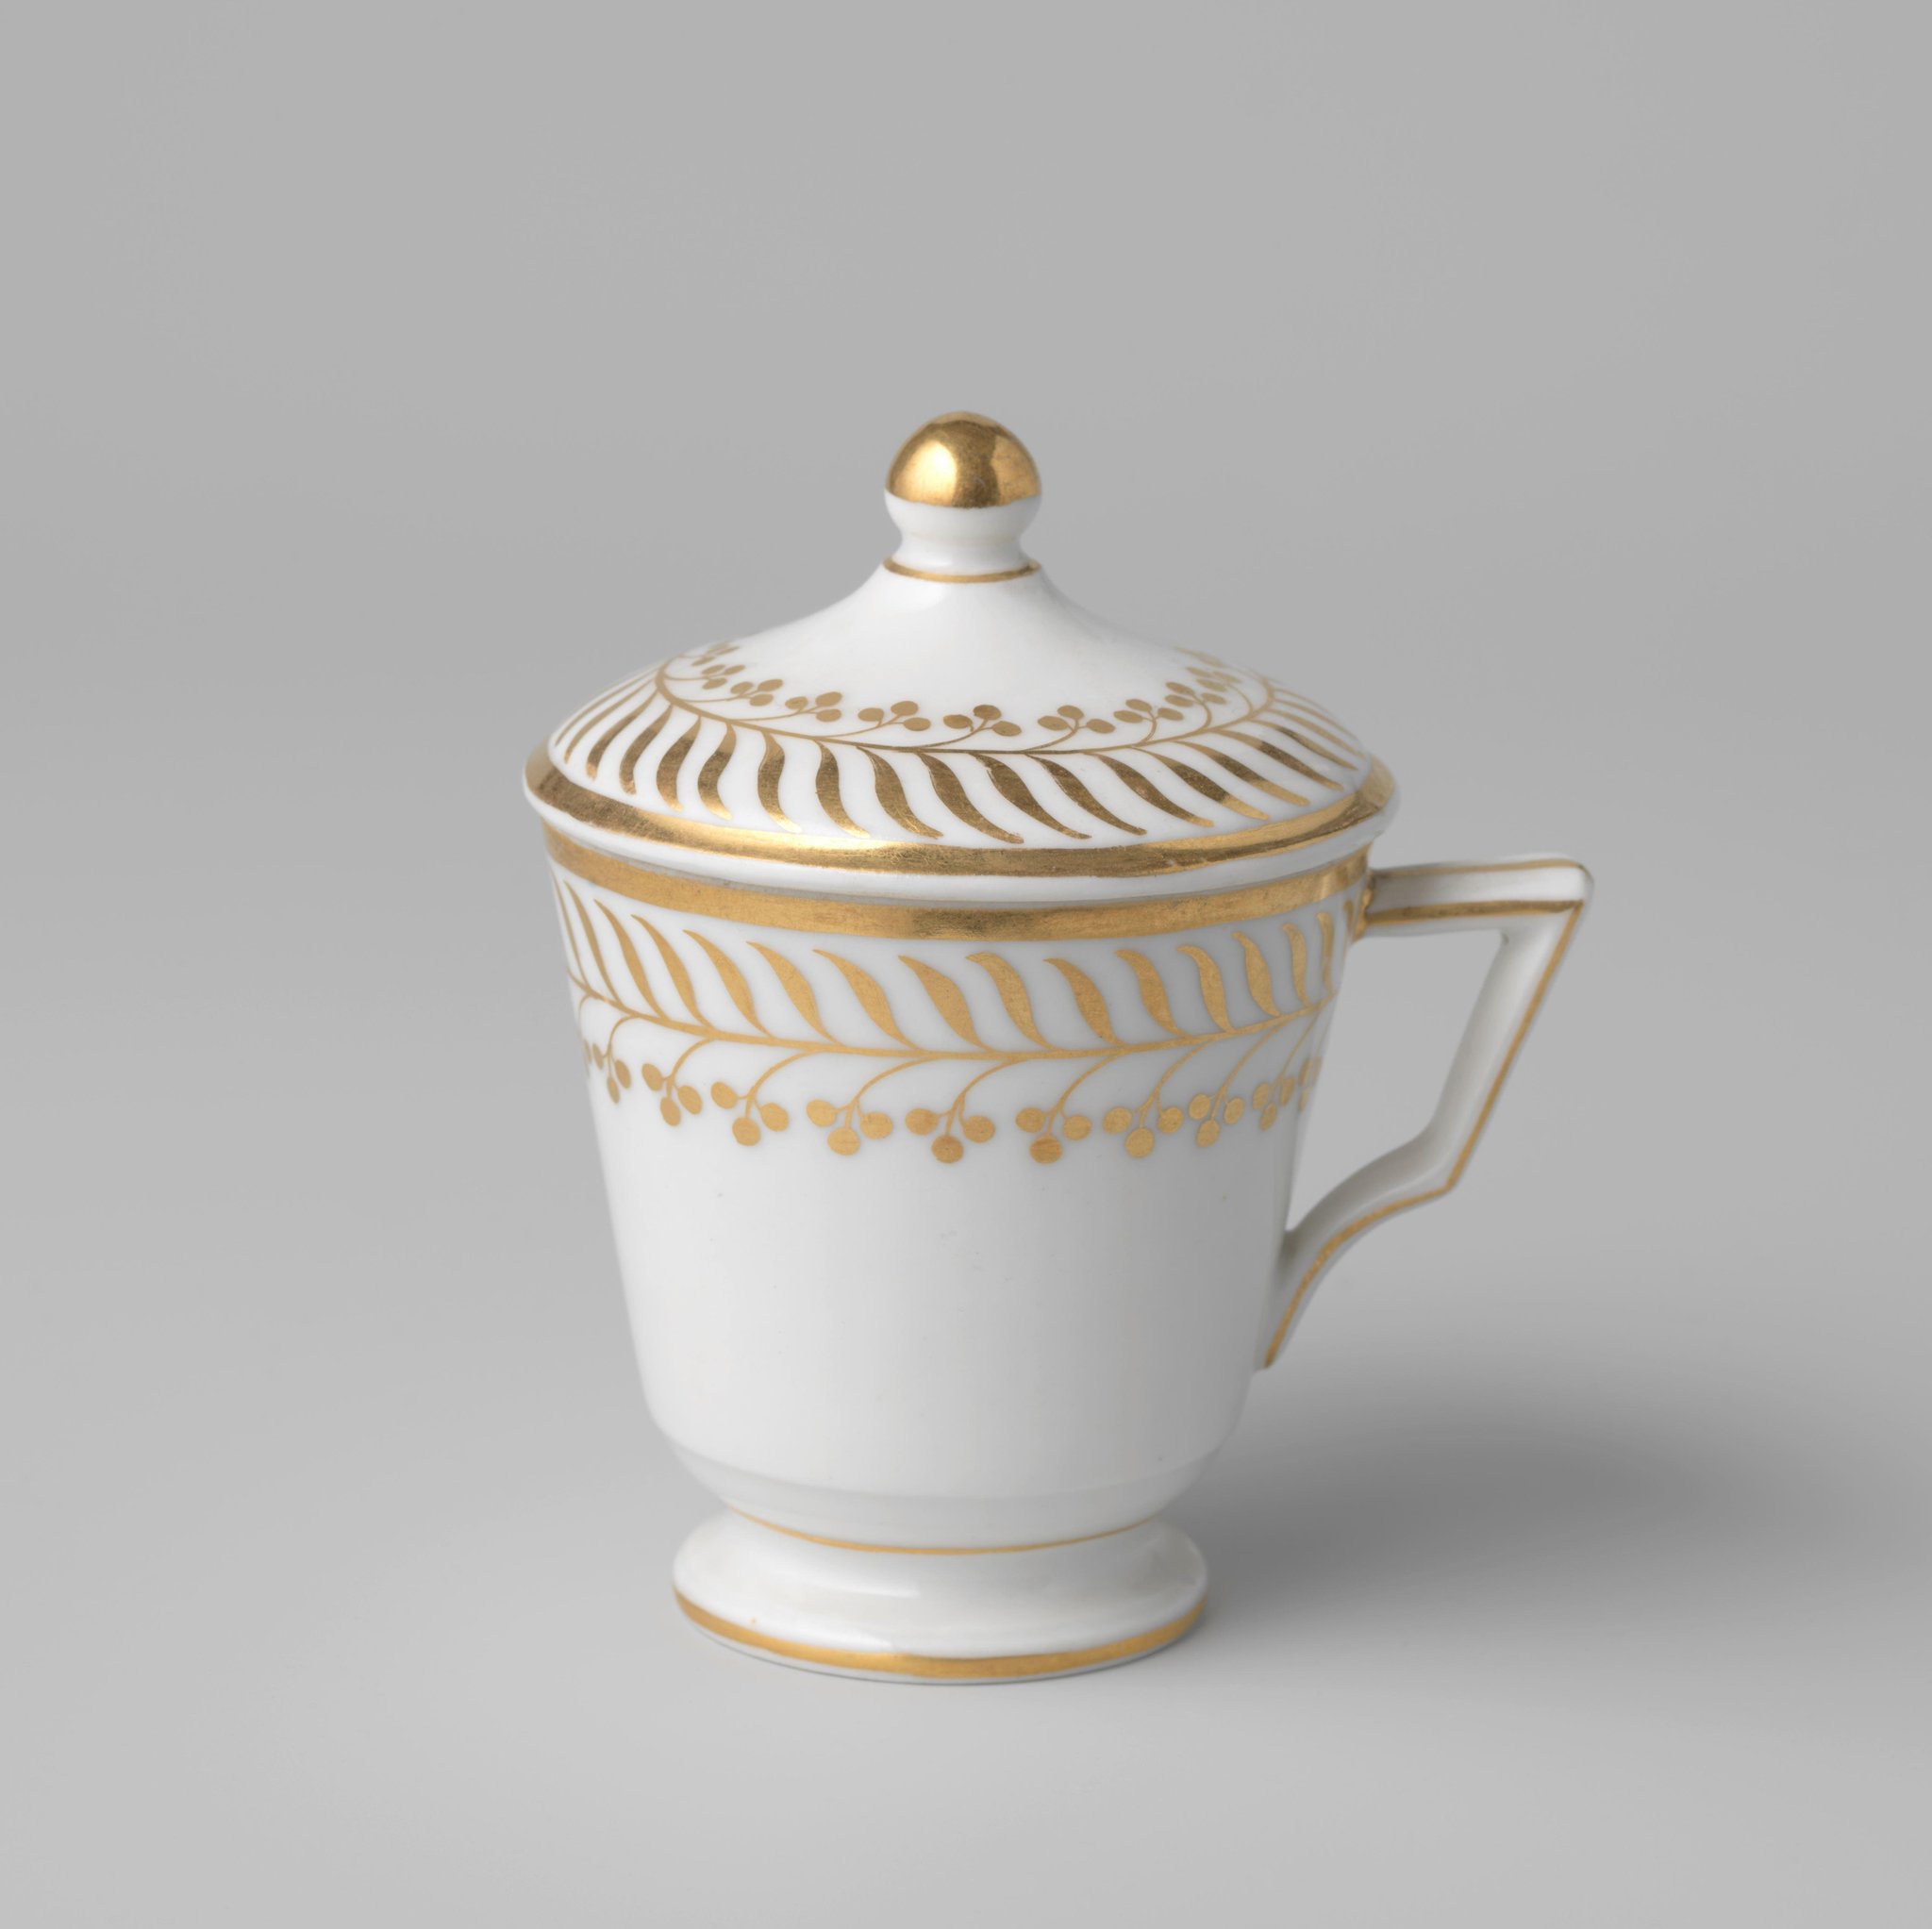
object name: service set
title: Covered cup (pot de crème) with stylized floral scrolls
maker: Anonymous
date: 1800-1810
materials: glaze, gold, paint, porcelain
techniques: firing, forming, gilding, vitrification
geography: france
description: Crêmepot van porselein met oor. Versierd met gouden biezen en langs de randen beschilderd met een doorlopende tak met aan de ene zijde bladeren, aan de andere zijde steeds een tak met drie vruchten. Gemerkt met ingegrifte 1.